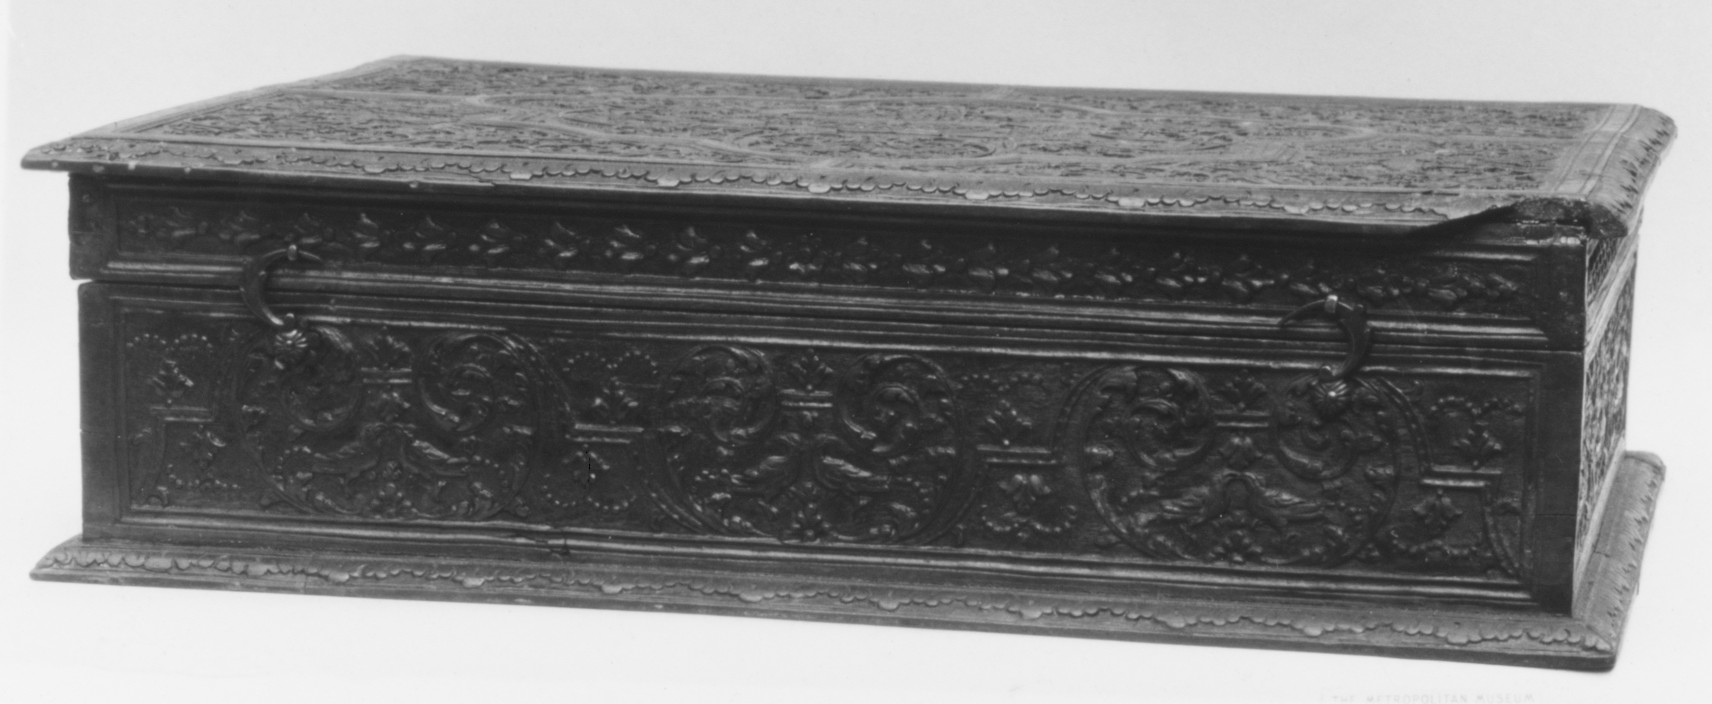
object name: box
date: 1667-1733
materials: wood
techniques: carving